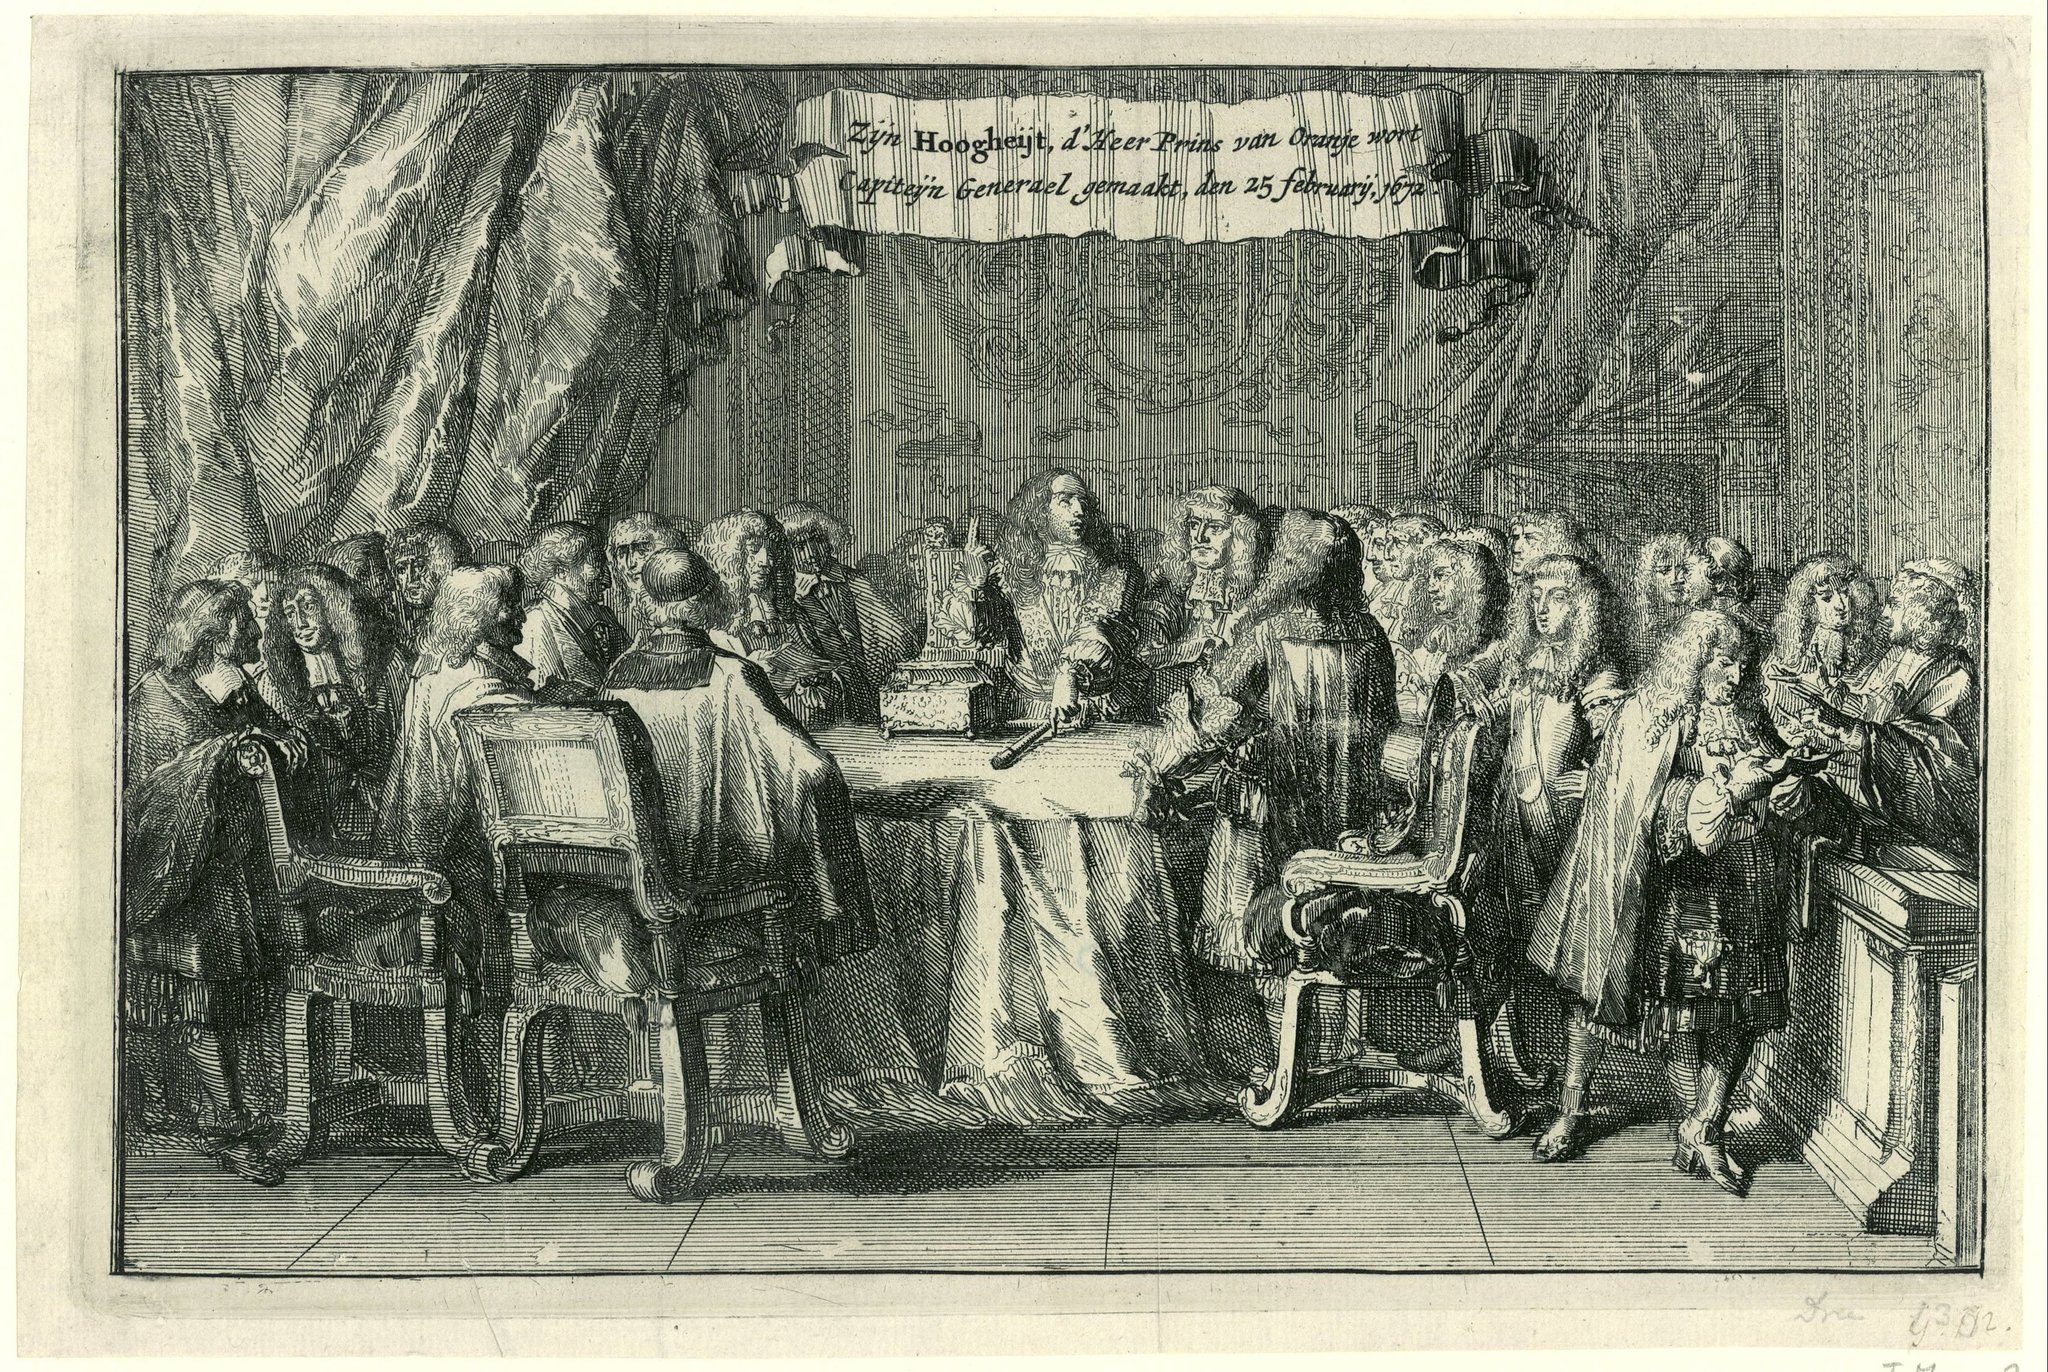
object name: history print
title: Zijn Hoogheijt, d'heer prins van Oranje wort Capiteijn Generael gemaakt, den 25 februarij, 1672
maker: romeyn de hooghe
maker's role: draughtsman, goldsmith, painter, print maker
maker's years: 1645-1708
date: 1672-1674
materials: paper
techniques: etching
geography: northern netherlands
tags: the hague, william iii (prince of orange and king of england, scotland, and ireland), new ruler taking the oath, taking the oath ~ military service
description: Prent ook gebruikt in: Domselaer, T. van. Het ontroerde Nederlandt, door de wapenen des konings van Vrankryk […]. 2 delen. Amsterdam: Marcus Willemsz. Doornick, 1674-1676, dl. 1 (1674), p. 78. De plaat is later aangepast (door iemand anders dan De Hooghe) en gebruikt voor een prent van de benoeming van Willem III tot stadhouder (FM 2378, zie RP-P-OB-77.107 en RP-P-AO-12-84).